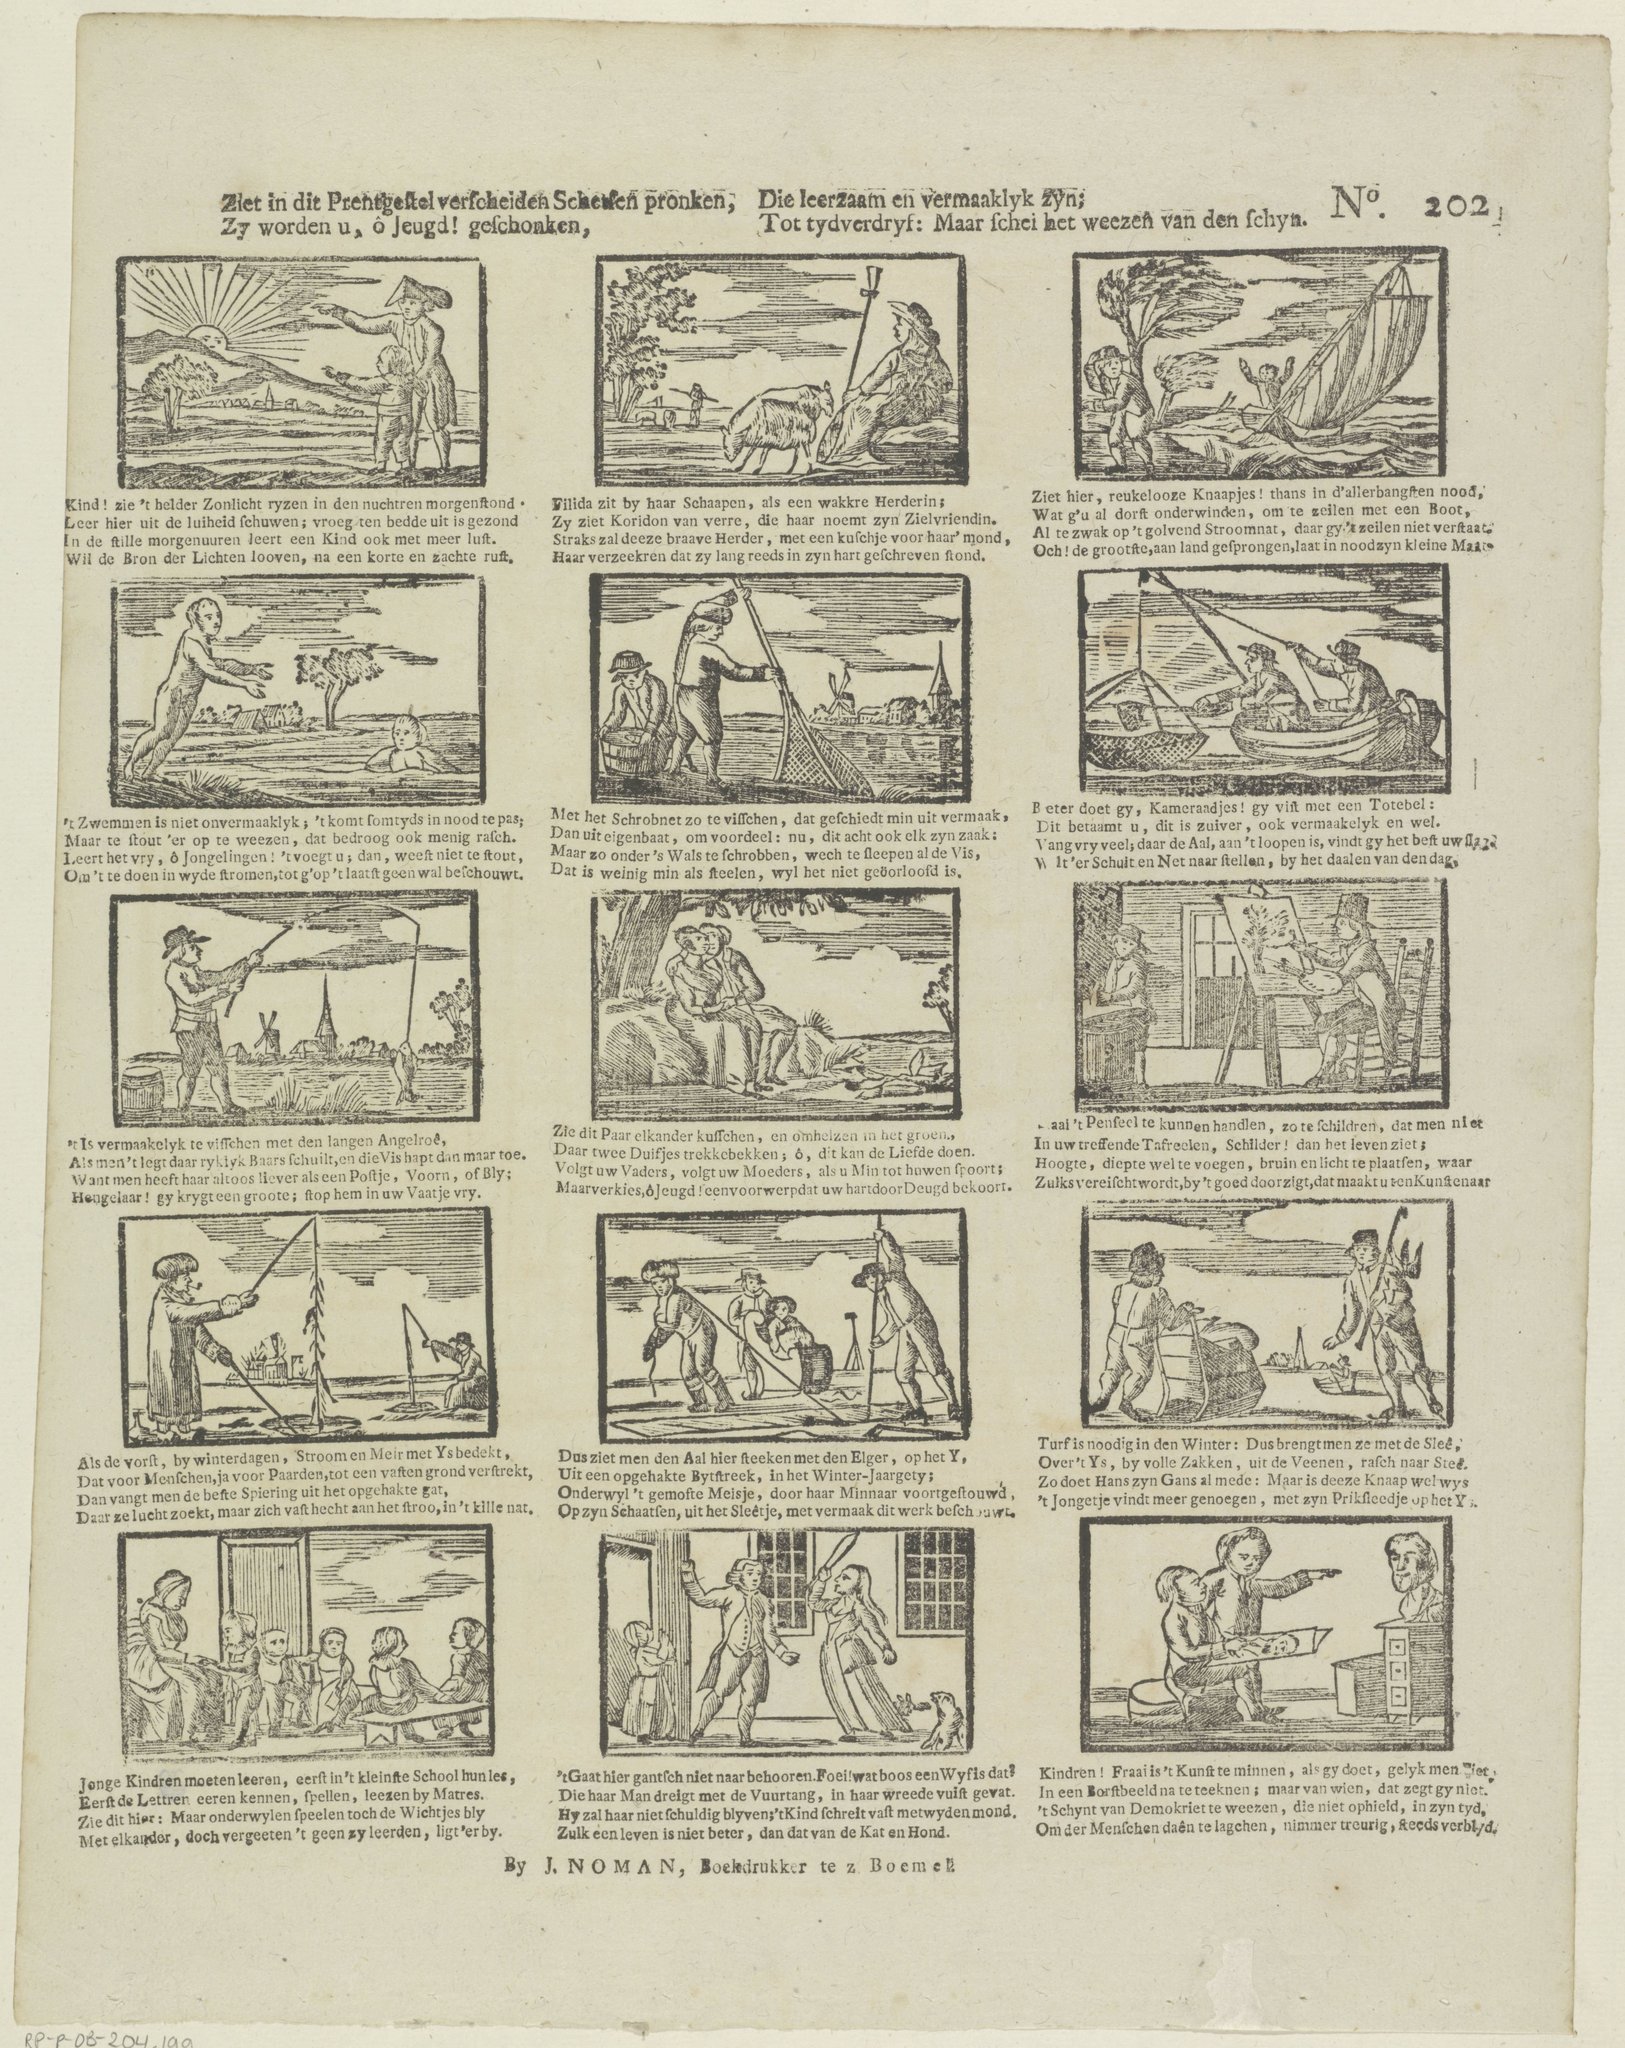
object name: popular print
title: Ziet in dit prentgestel verscheiden schetsen pronken, / Zy worden u, ô jeugd! geschonken, / Die leerzaam en vermaaklyk zyn; / Tot tydverdryf: Maar schei het weezen van den schyn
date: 1806-1830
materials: paper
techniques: letterpress printing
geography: netherlands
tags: herding, herdsman, herdswoman, shepherd, shepherdess, cowherd, etc., drawing-lesson, fisherman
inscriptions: collector's mark: Lugt 2760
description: Blad met 15 voorstellingen van beroepen en bezigheden, zoals zeilen, vissen en tekenen. Onder elke afbeelding een vierregelig vers. Genummerd rechtsboven: No. 202.